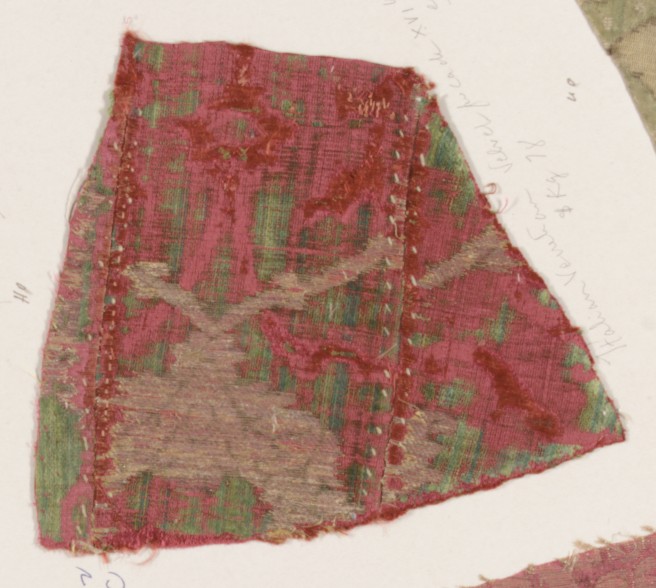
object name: fragment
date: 1501-1700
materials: metal thread, silk